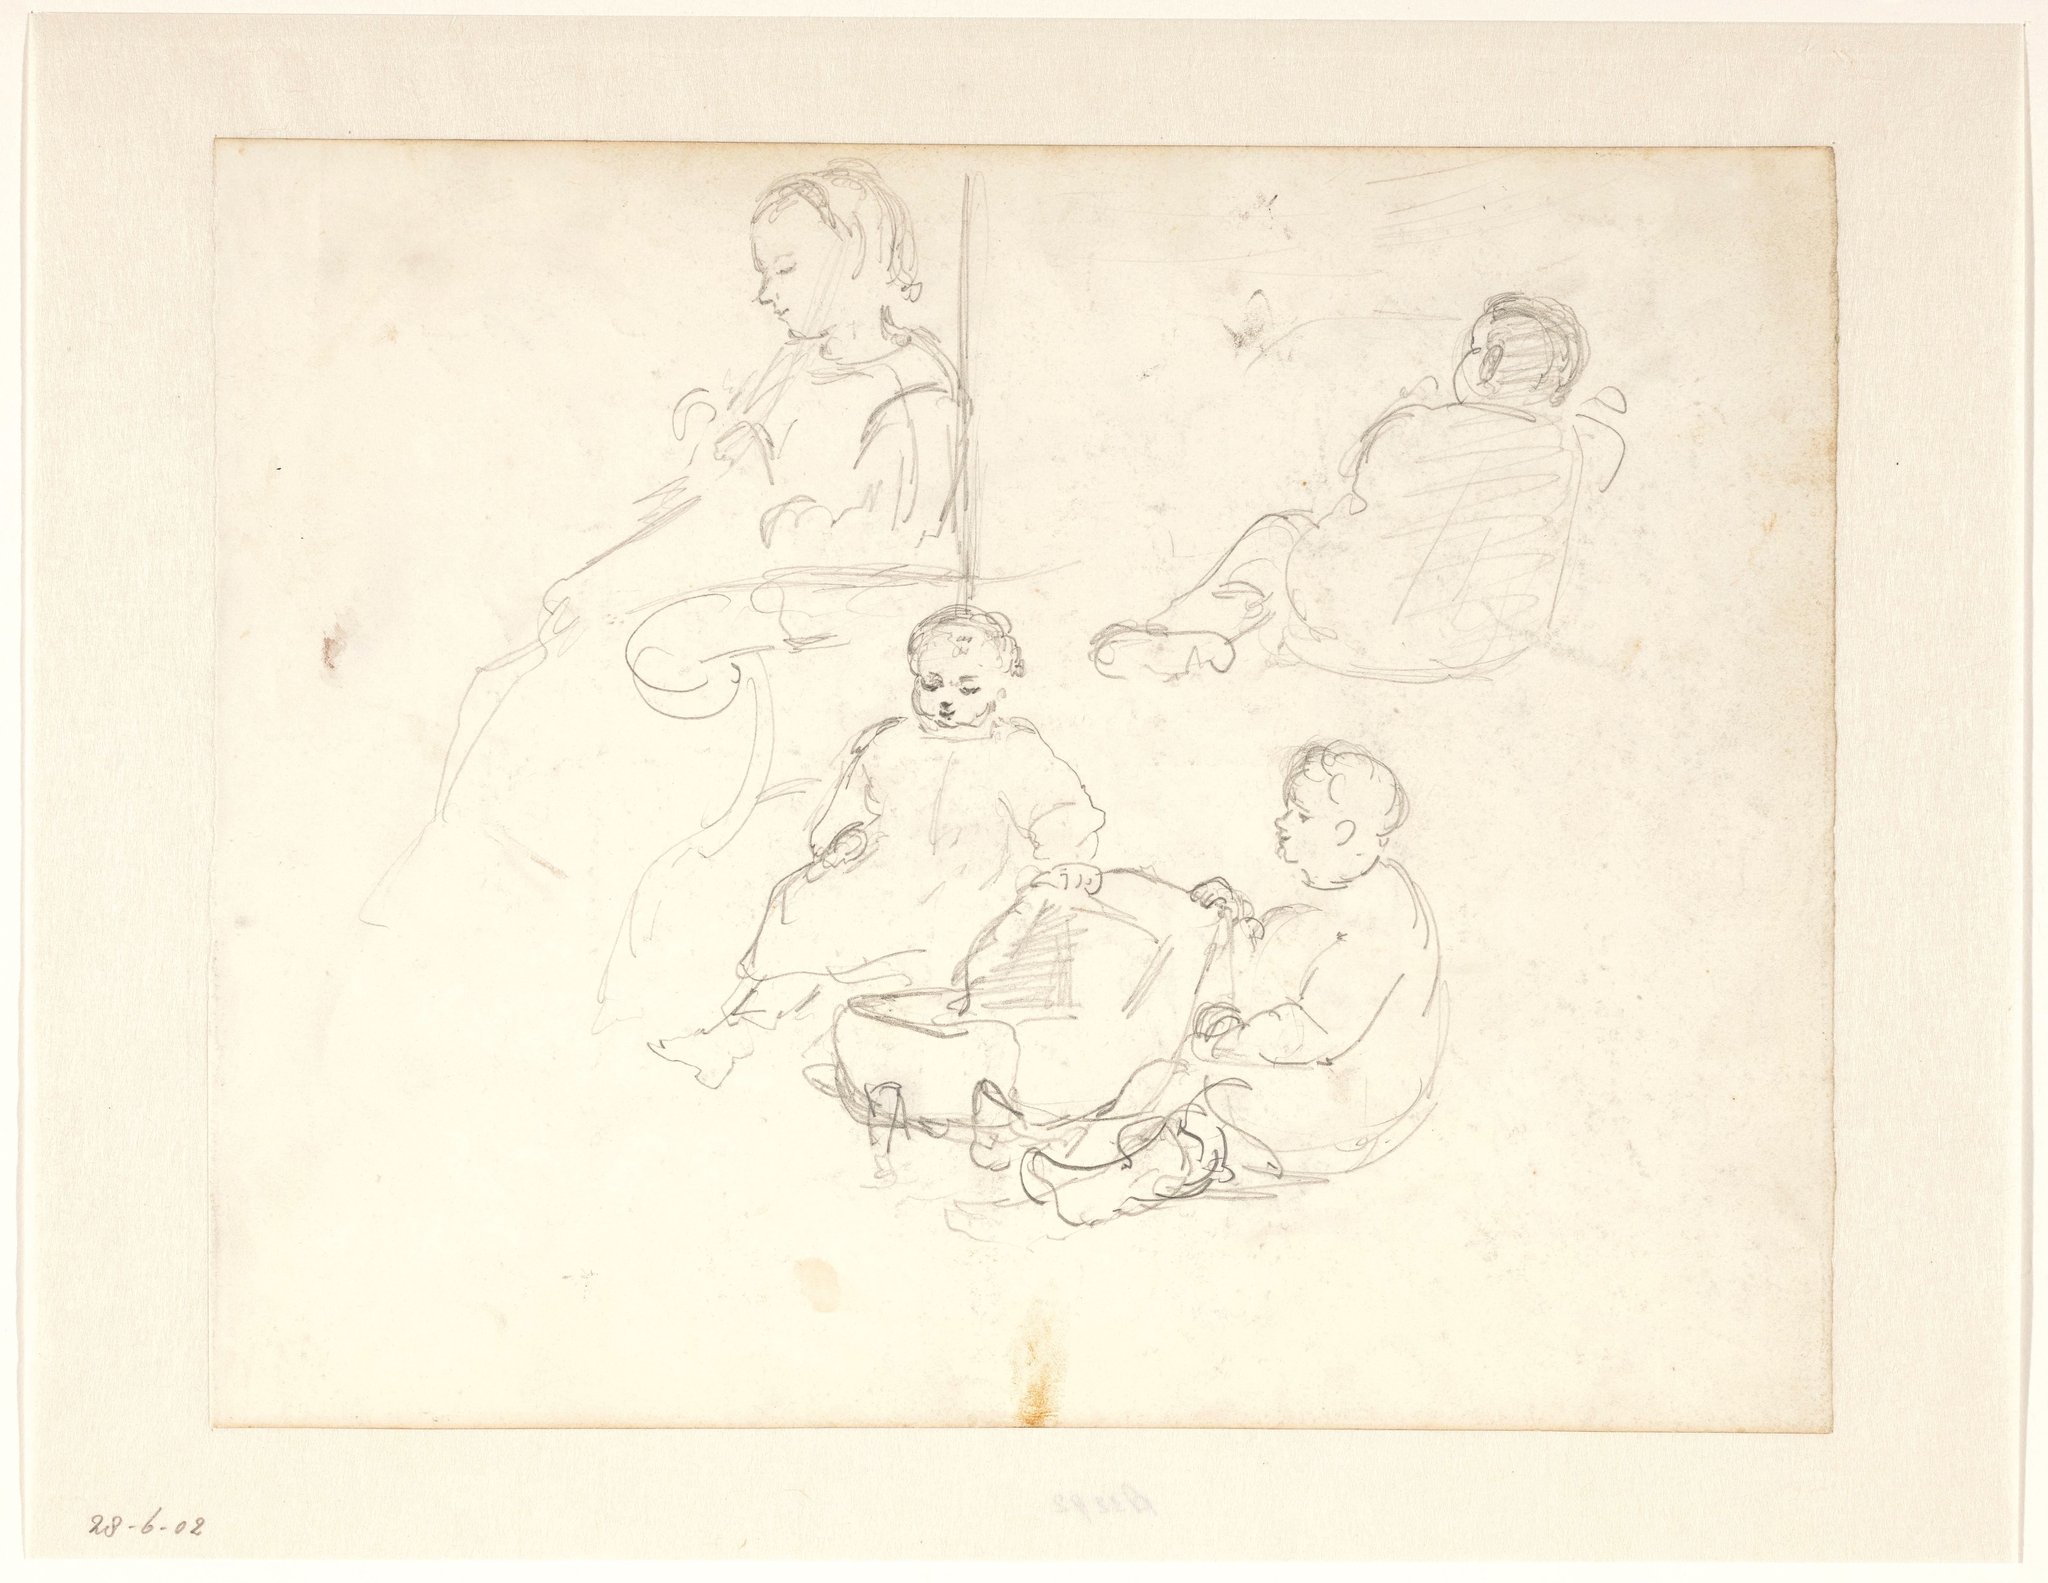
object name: drawing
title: Vier schetsen van kinderen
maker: hendrik valkenburg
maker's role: draughtsman, painter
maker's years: 1826-1896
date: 1836-1896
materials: paper, pencil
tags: the first years ~ the ages of man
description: Vier schetsen van kinderen. Verso: vier ontwerpen van kostuums voor deelnemers in een optocht, met opmerkingen over kleuren.